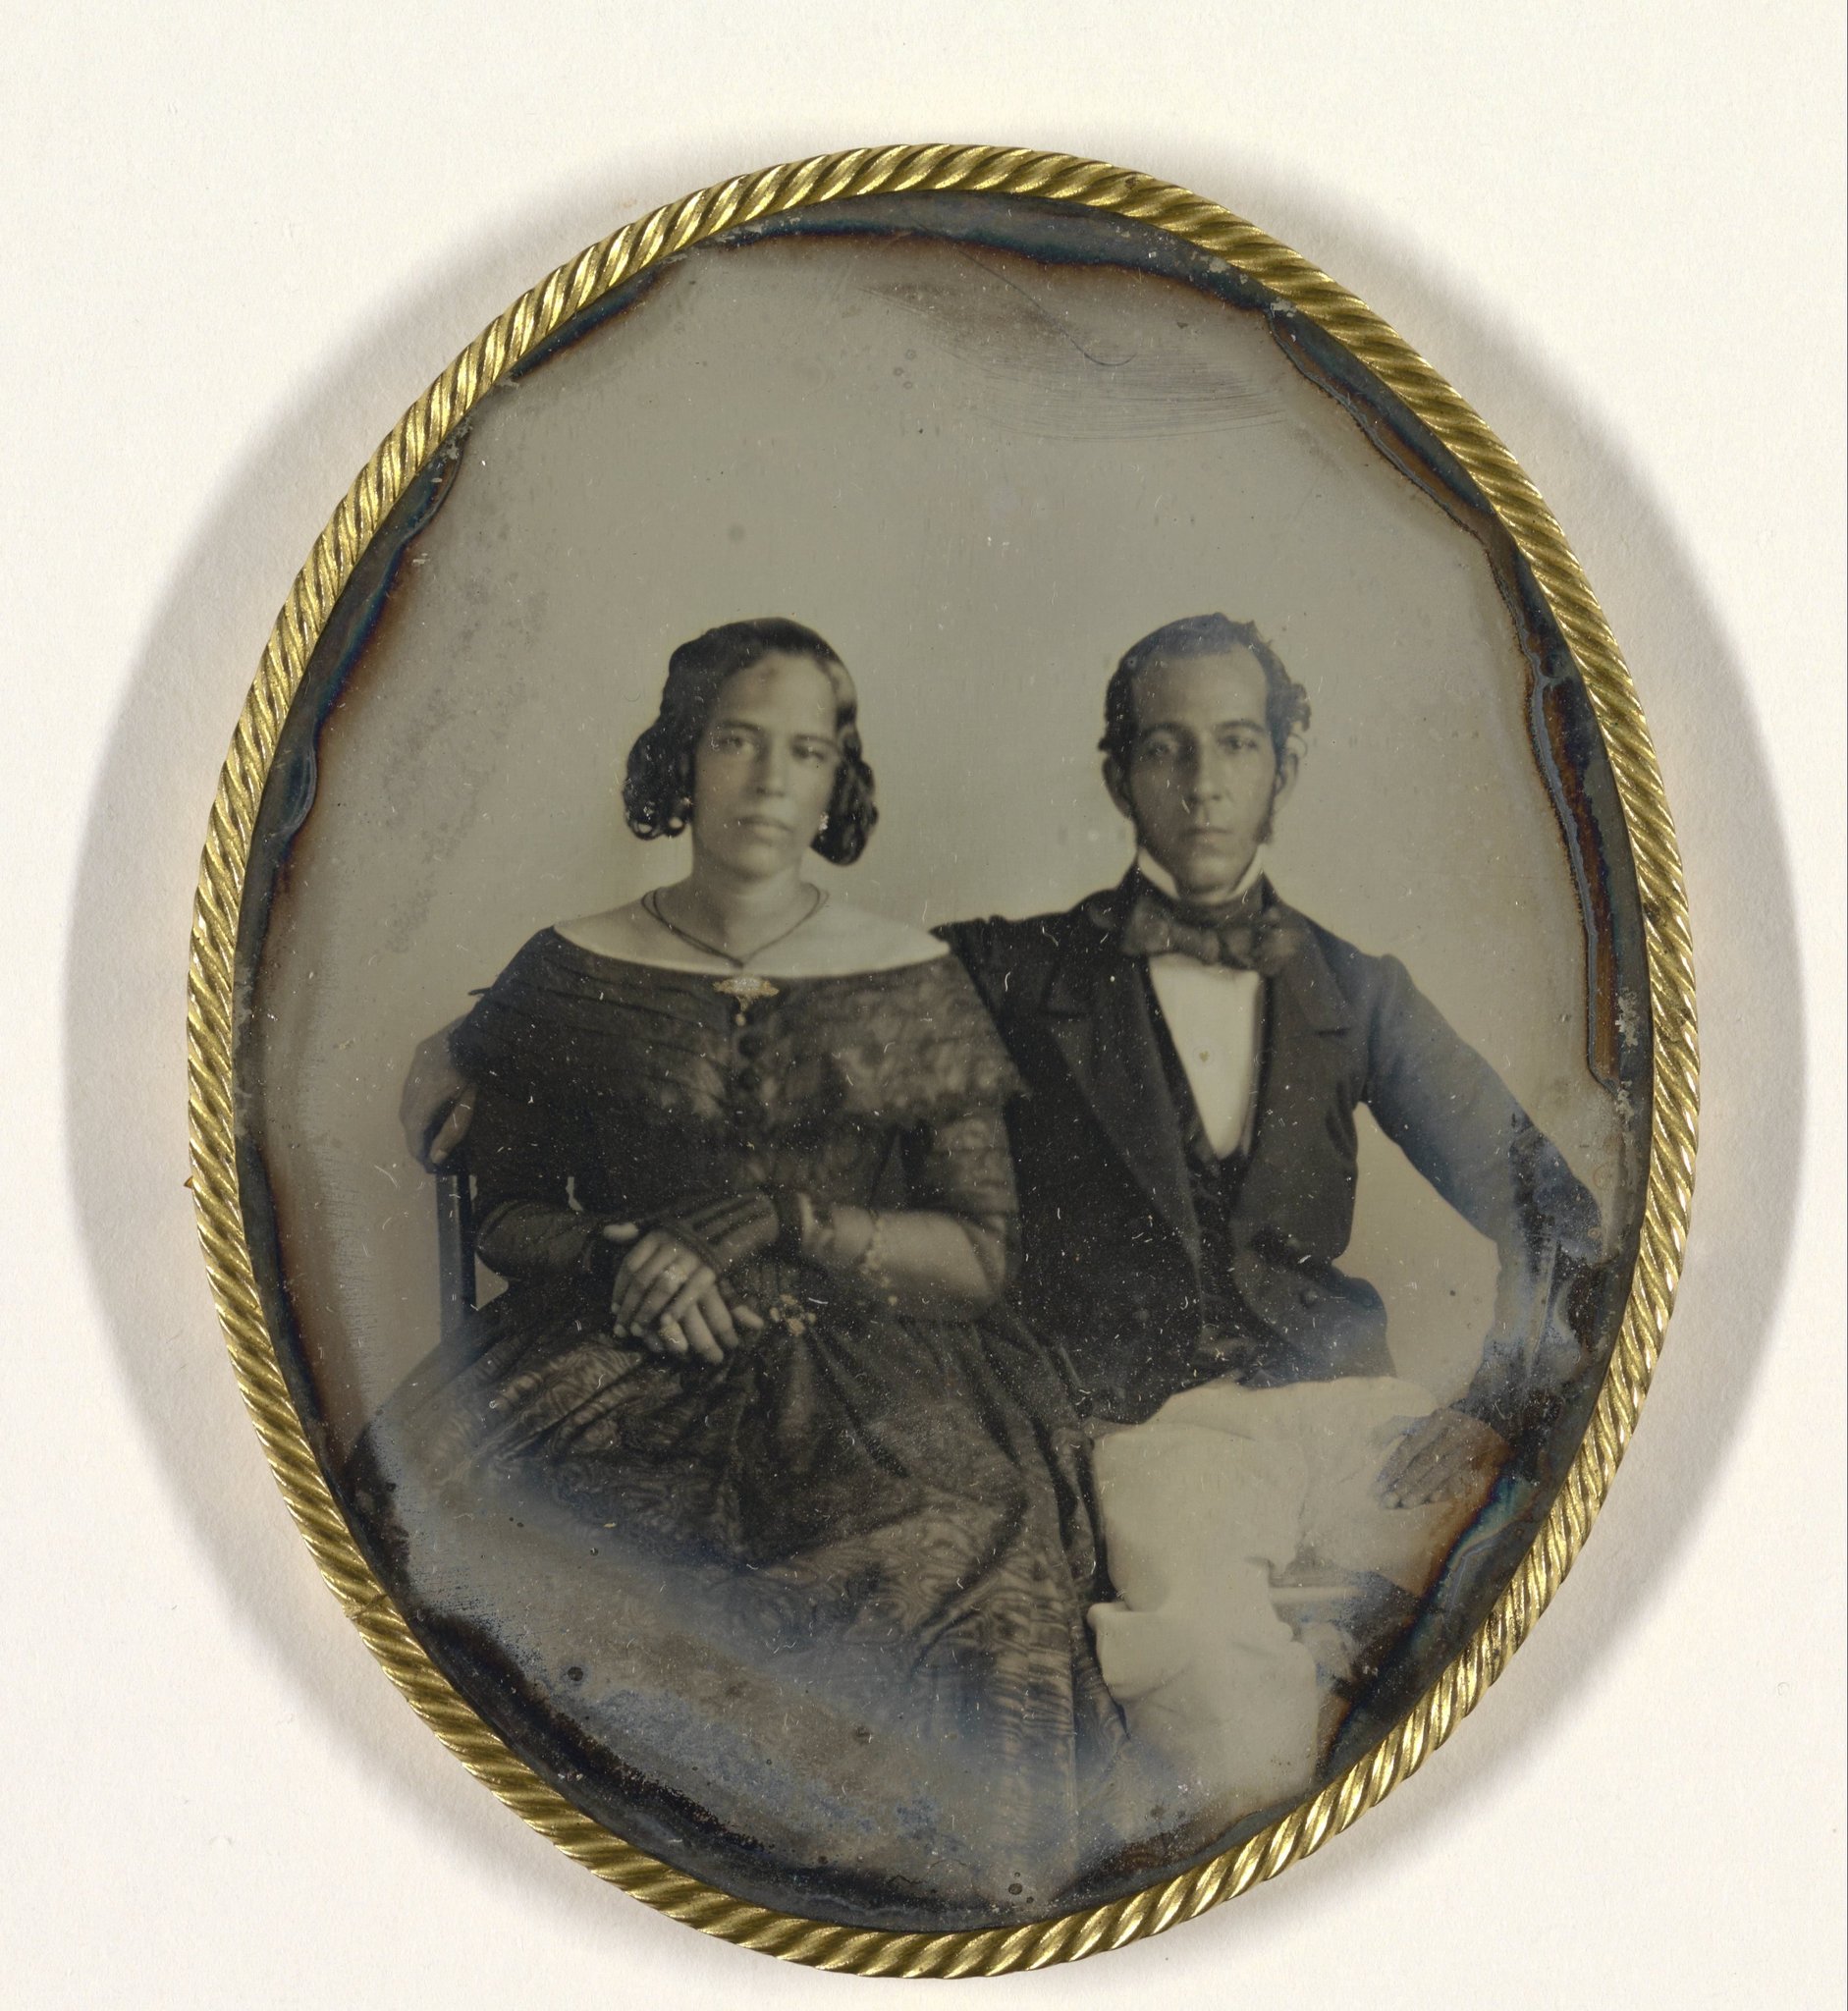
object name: photograph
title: Portrait of Johannes Ellis and his Wife Maria Louisa de Hart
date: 1846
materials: brass, copper, glass, silver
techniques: daguerreotype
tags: suriname, the hague, amsterdam, marriage, married couple, 'matrimonium'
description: The young man portrayed here is 33-year old Johannes Ellis, who was born in Ghana. His beautiful wife is Maria Louisa de Hart, 19 years of age. The couple is wealthy and dressed in the latest fashion. According to family tradition, the portrait dates from the year they married, 1845. We now know that it was taken in Paramaribo by one of two travelling American daguerreotypists, who visited countries in the Carribean in the spring of 1846.